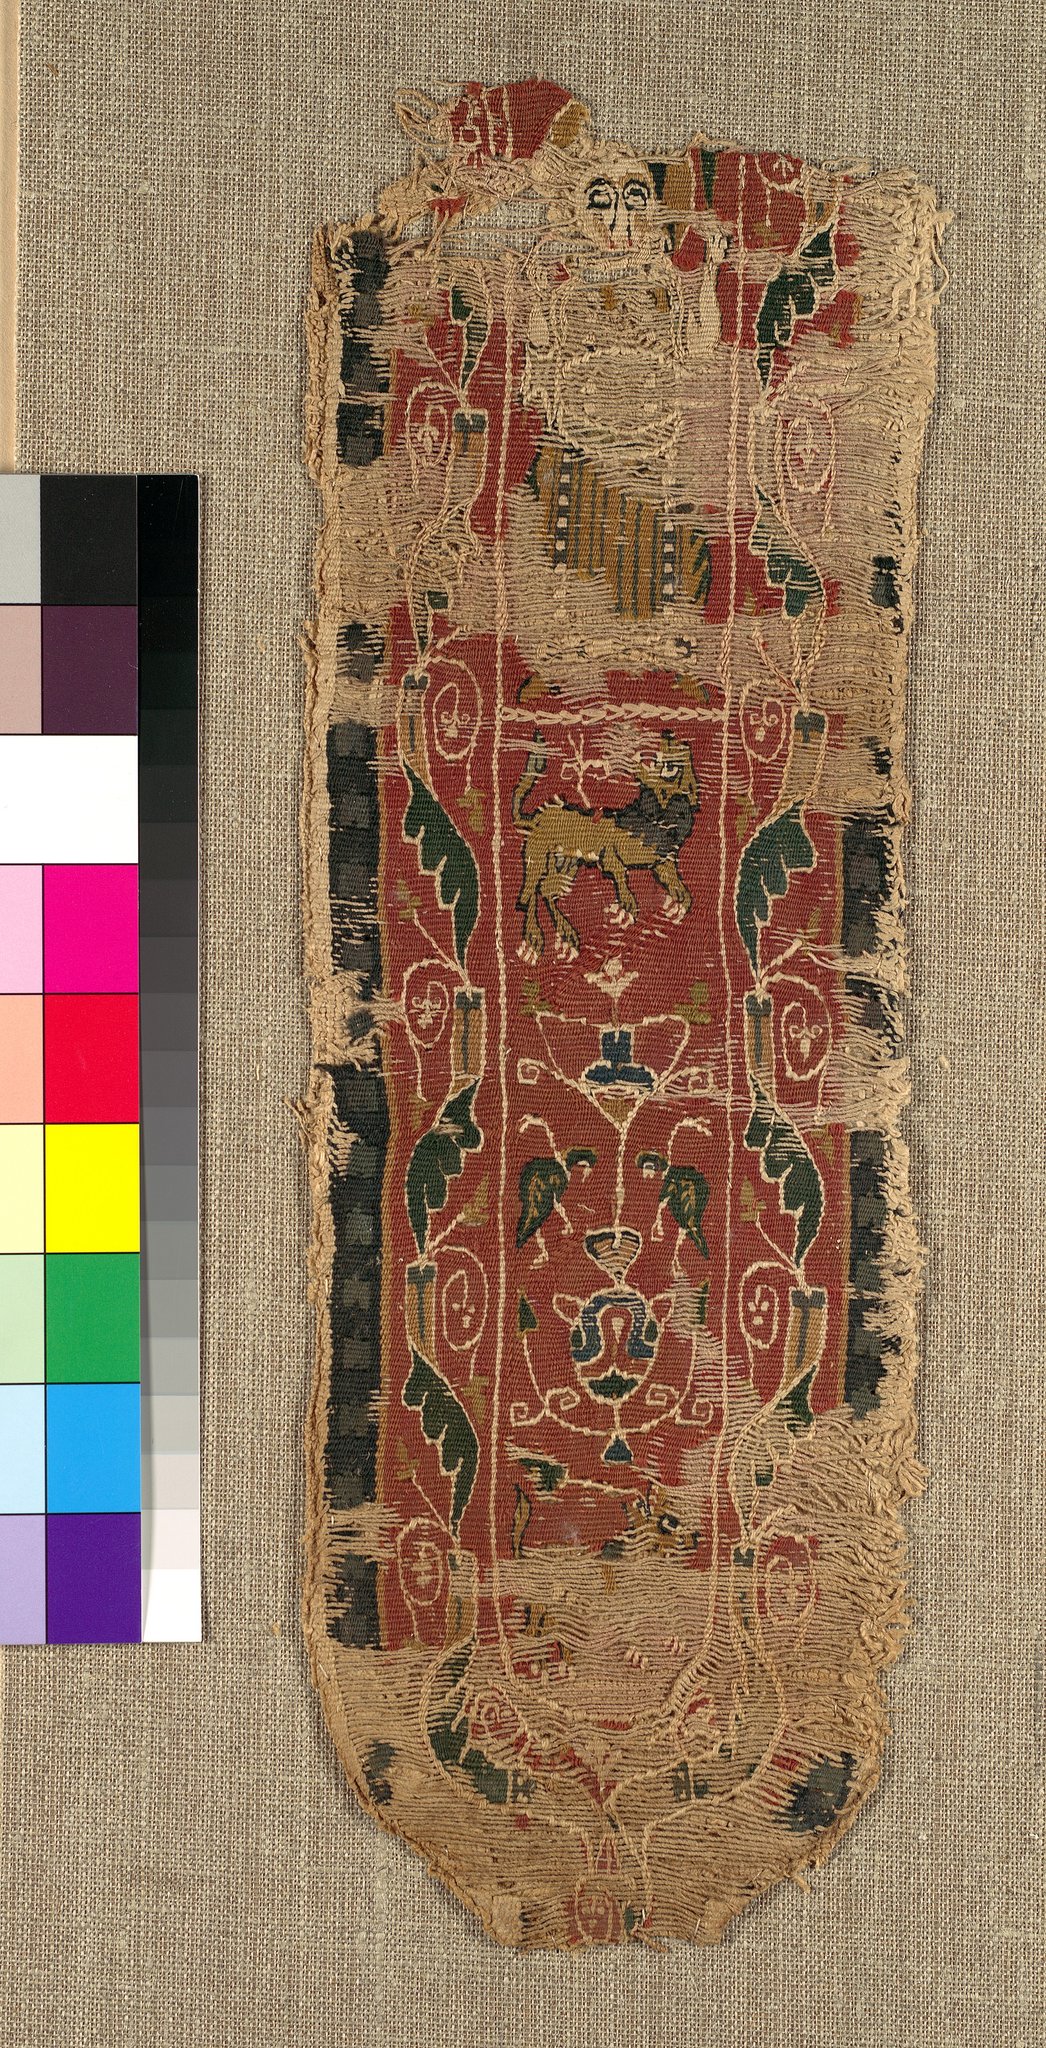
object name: textile fragment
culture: byzantine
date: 701-900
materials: linen, wool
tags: lions